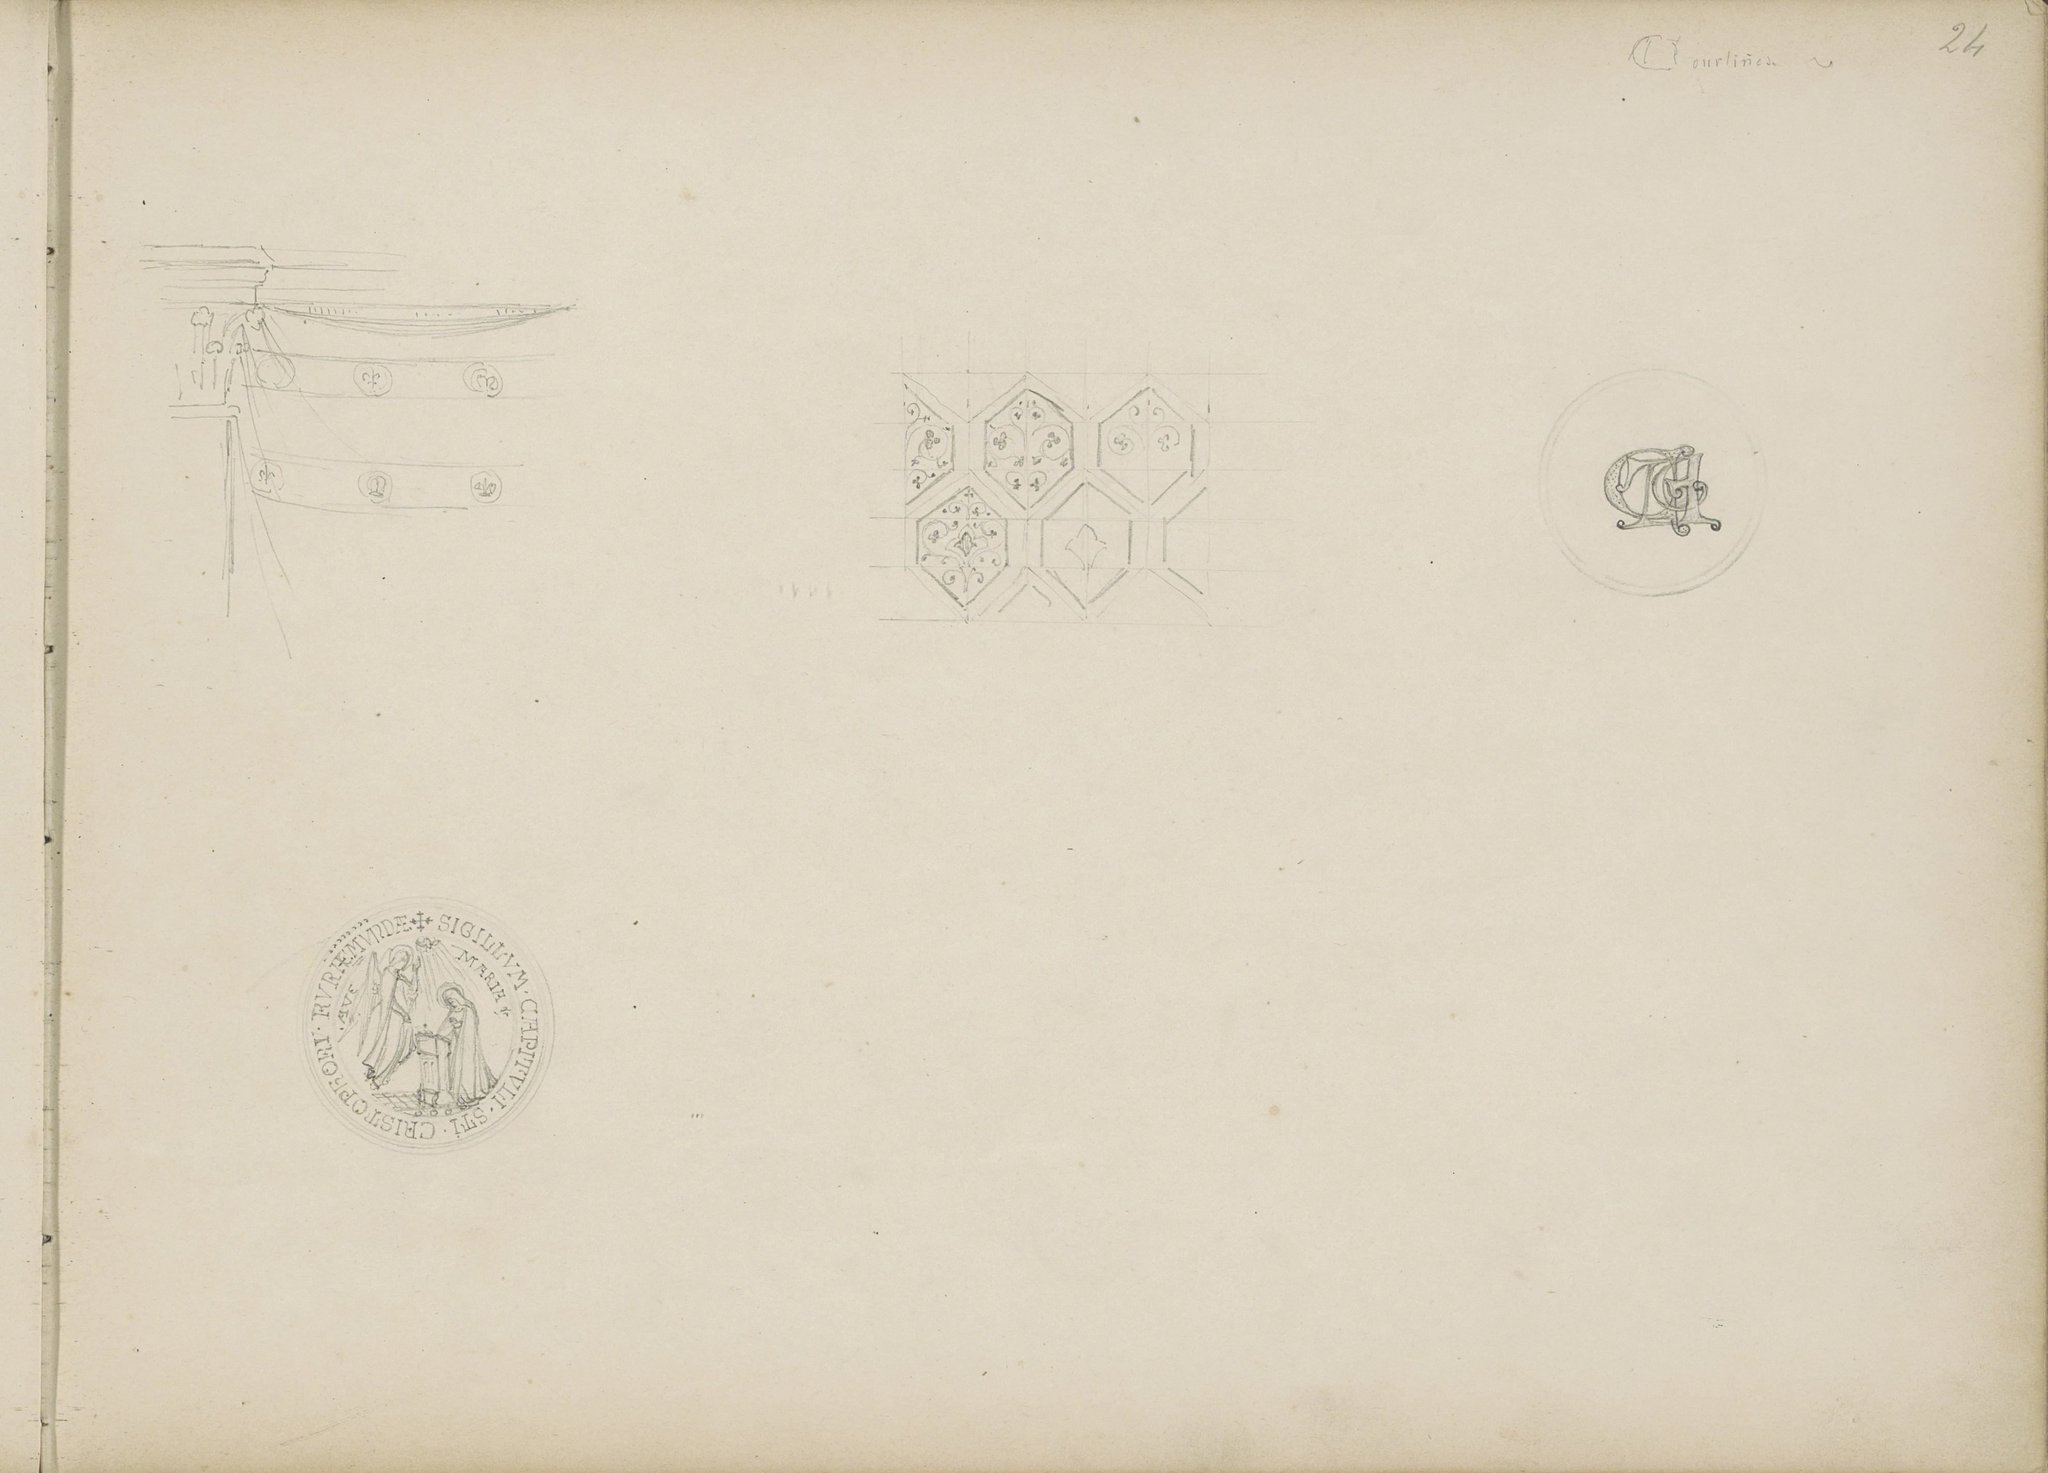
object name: sketchbook leaf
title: Studieblad, onder andere met een christelijke zegel en een monogram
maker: pierre joseph hubert cuypers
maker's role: draughtsman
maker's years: 1827-1921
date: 1857-1859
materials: paper, pencil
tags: magic mathematical figures; magic numbers, words, monograms, seal, stamp, architecture, the annunciation: mary, usually reading, is visited by the angel (sometimes a woman overhears the conversation), flowers ~ ornament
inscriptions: annotation: ‘Courtines’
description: De zegel toont de verkondiging aan Maria. Tevens een studie van een wand en een decoratief patroon met florale elementen. Blad 24 recto uit een schetsboek met 77 bladen.